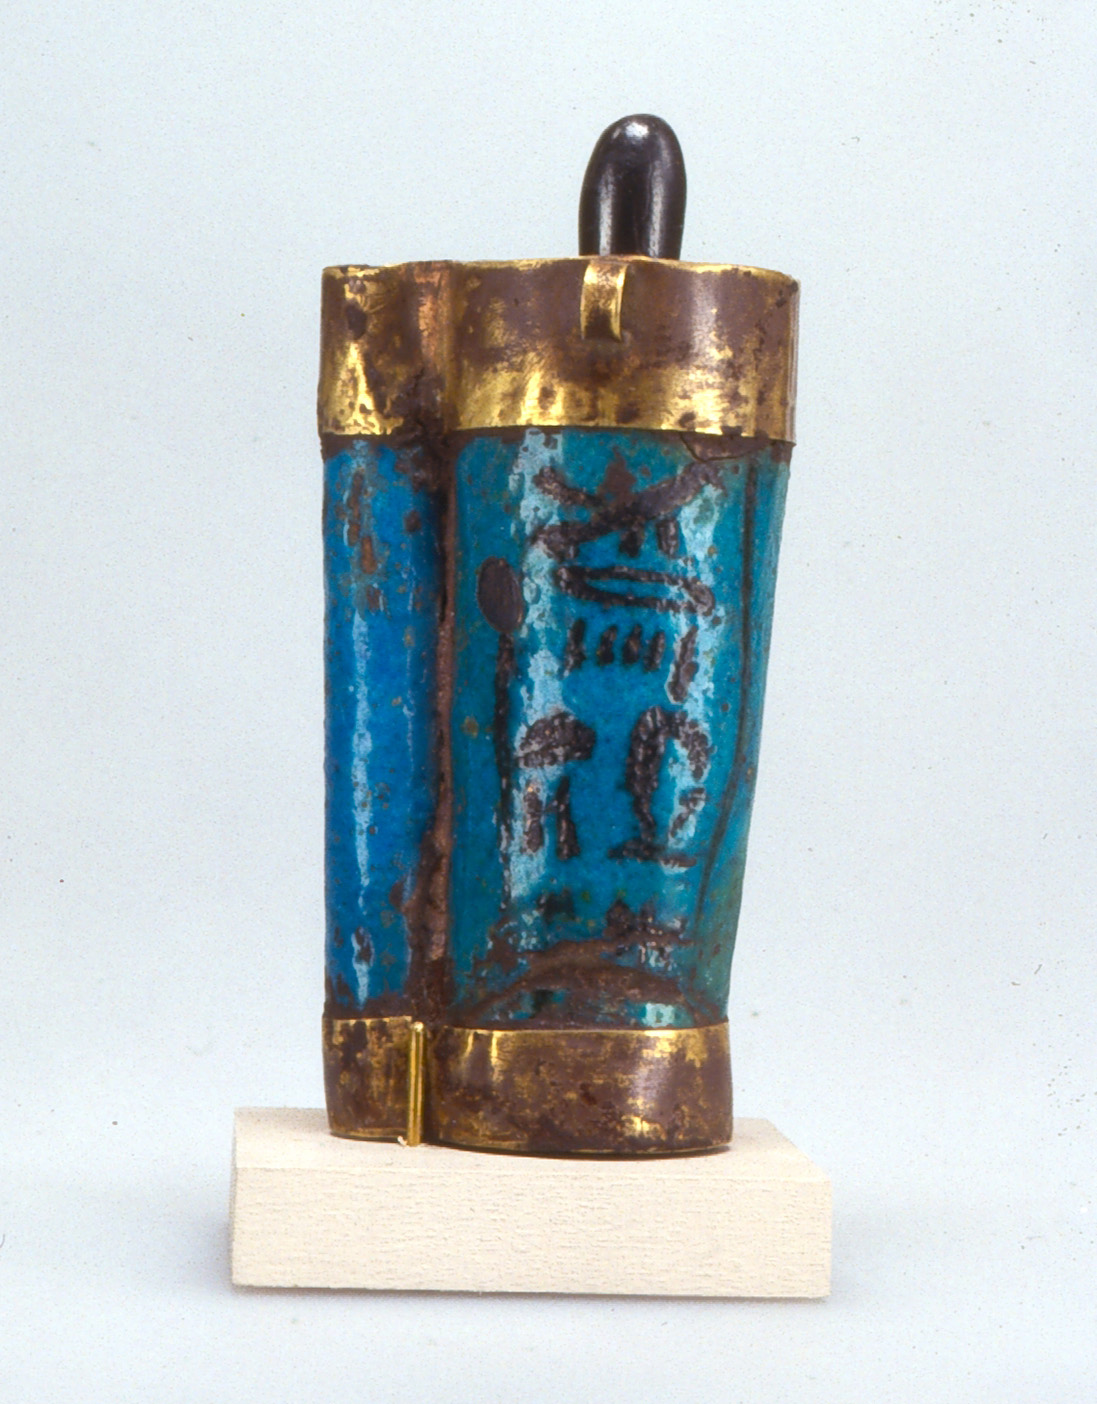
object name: kohl tube, stick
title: Kohl Tube and Applicator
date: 1550-1295 BCE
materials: faience, gold, mineral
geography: egypt